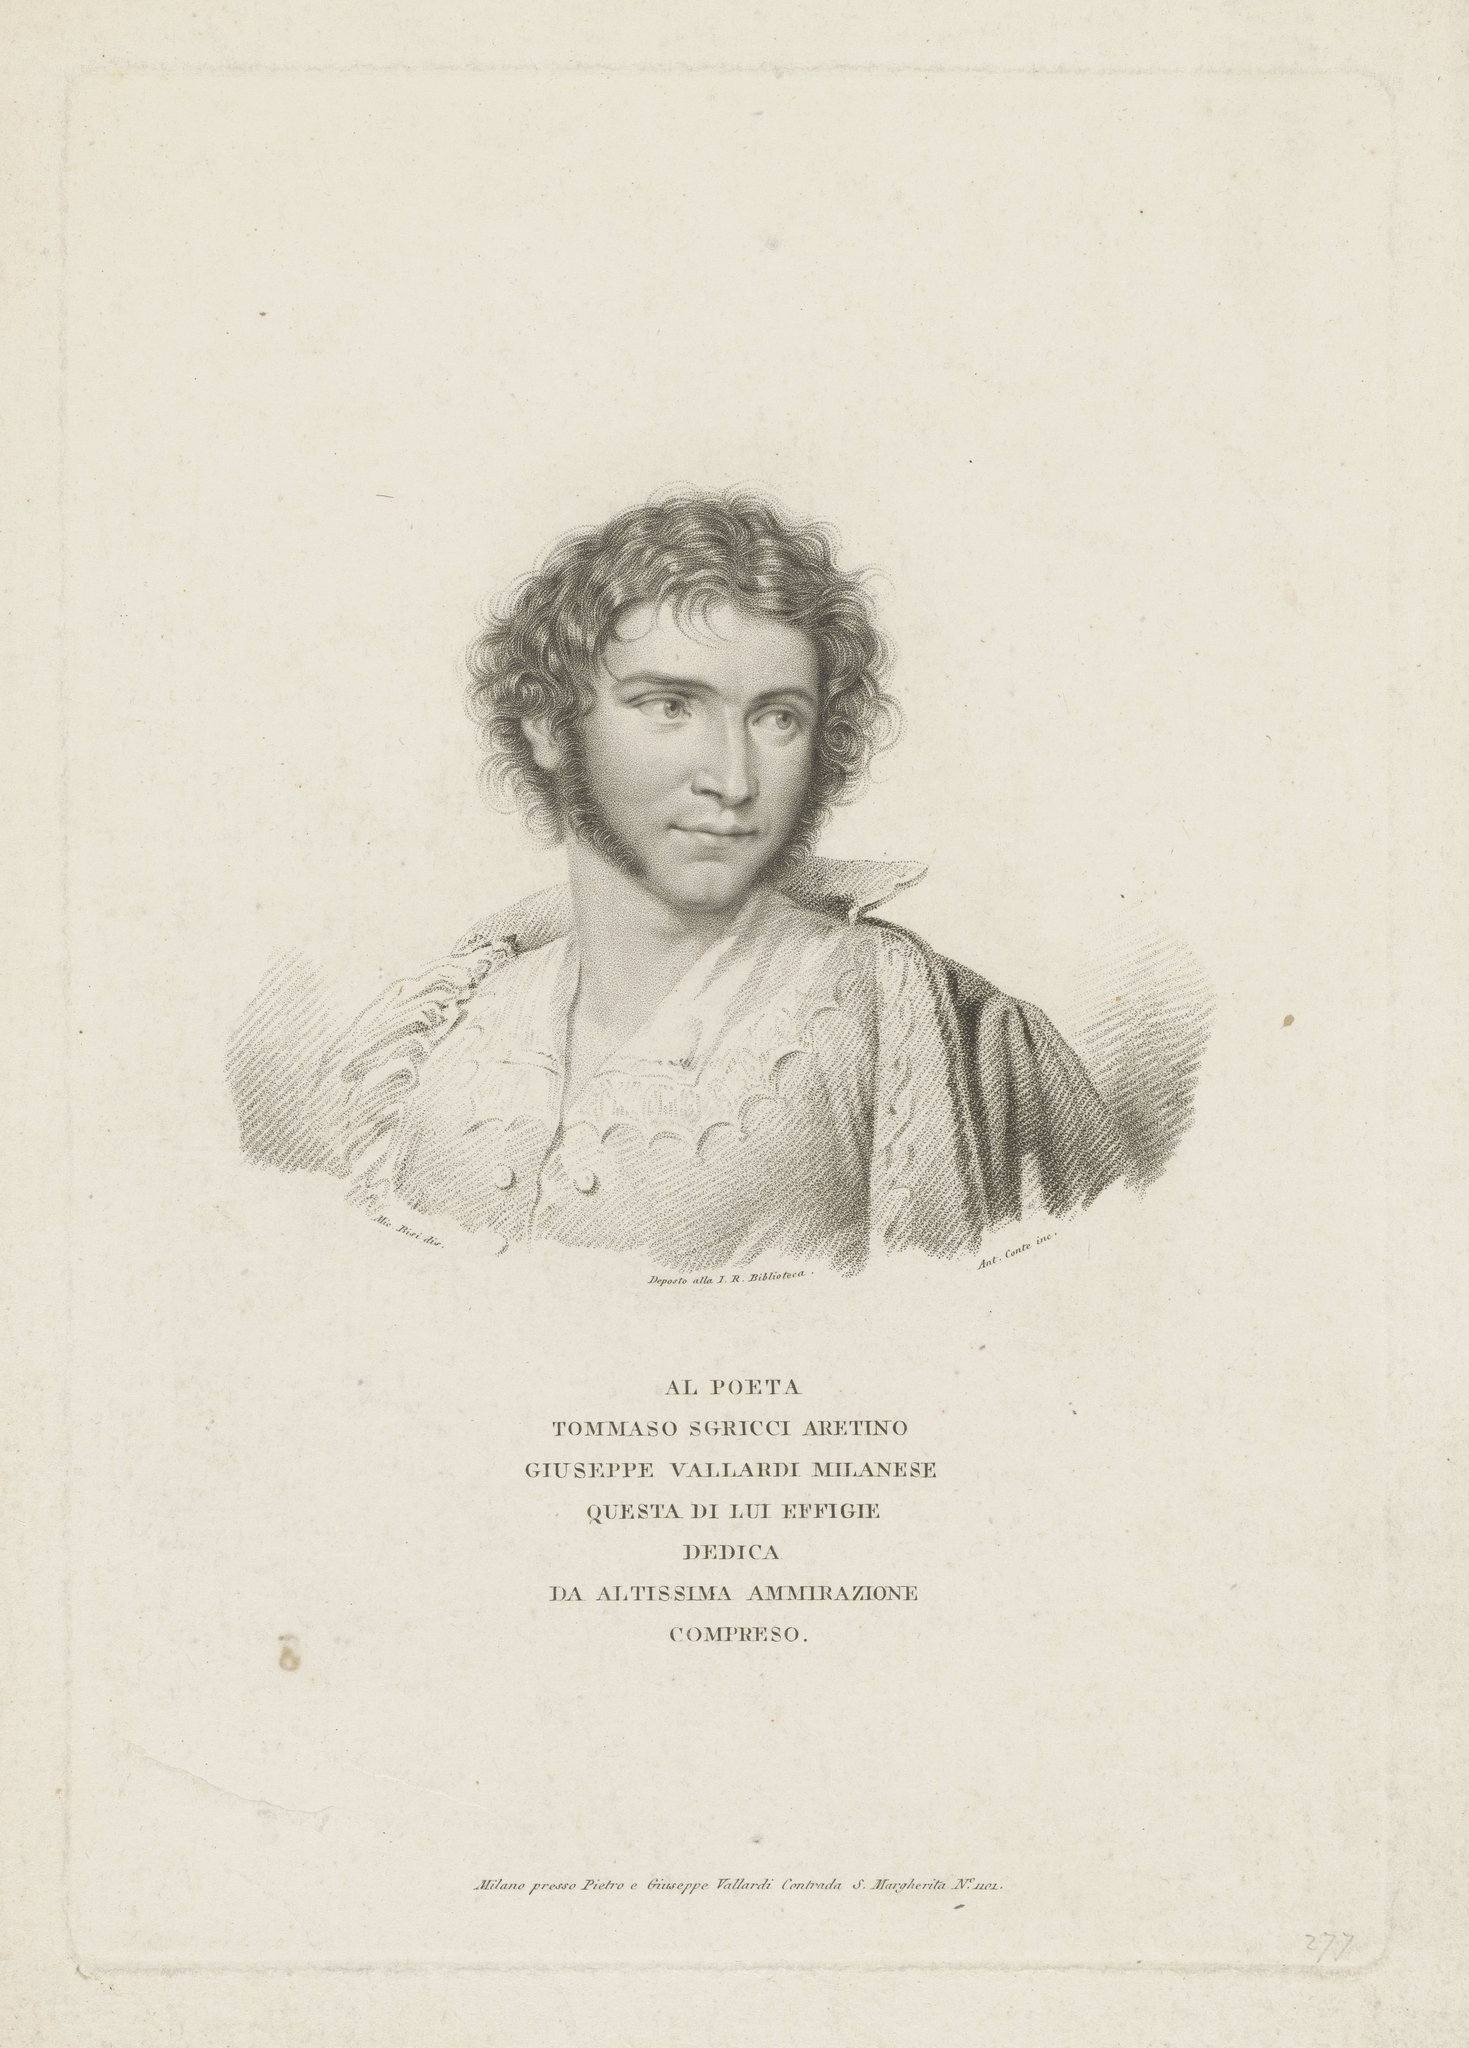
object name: print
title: Portret van acteur Tommaso Sgricci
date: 1790-1890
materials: paper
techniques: stippling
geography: italy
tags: historical persons, portrait of actor, actress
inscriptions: collector's mark: ‘V G’, collector's mark: Lugt 2228